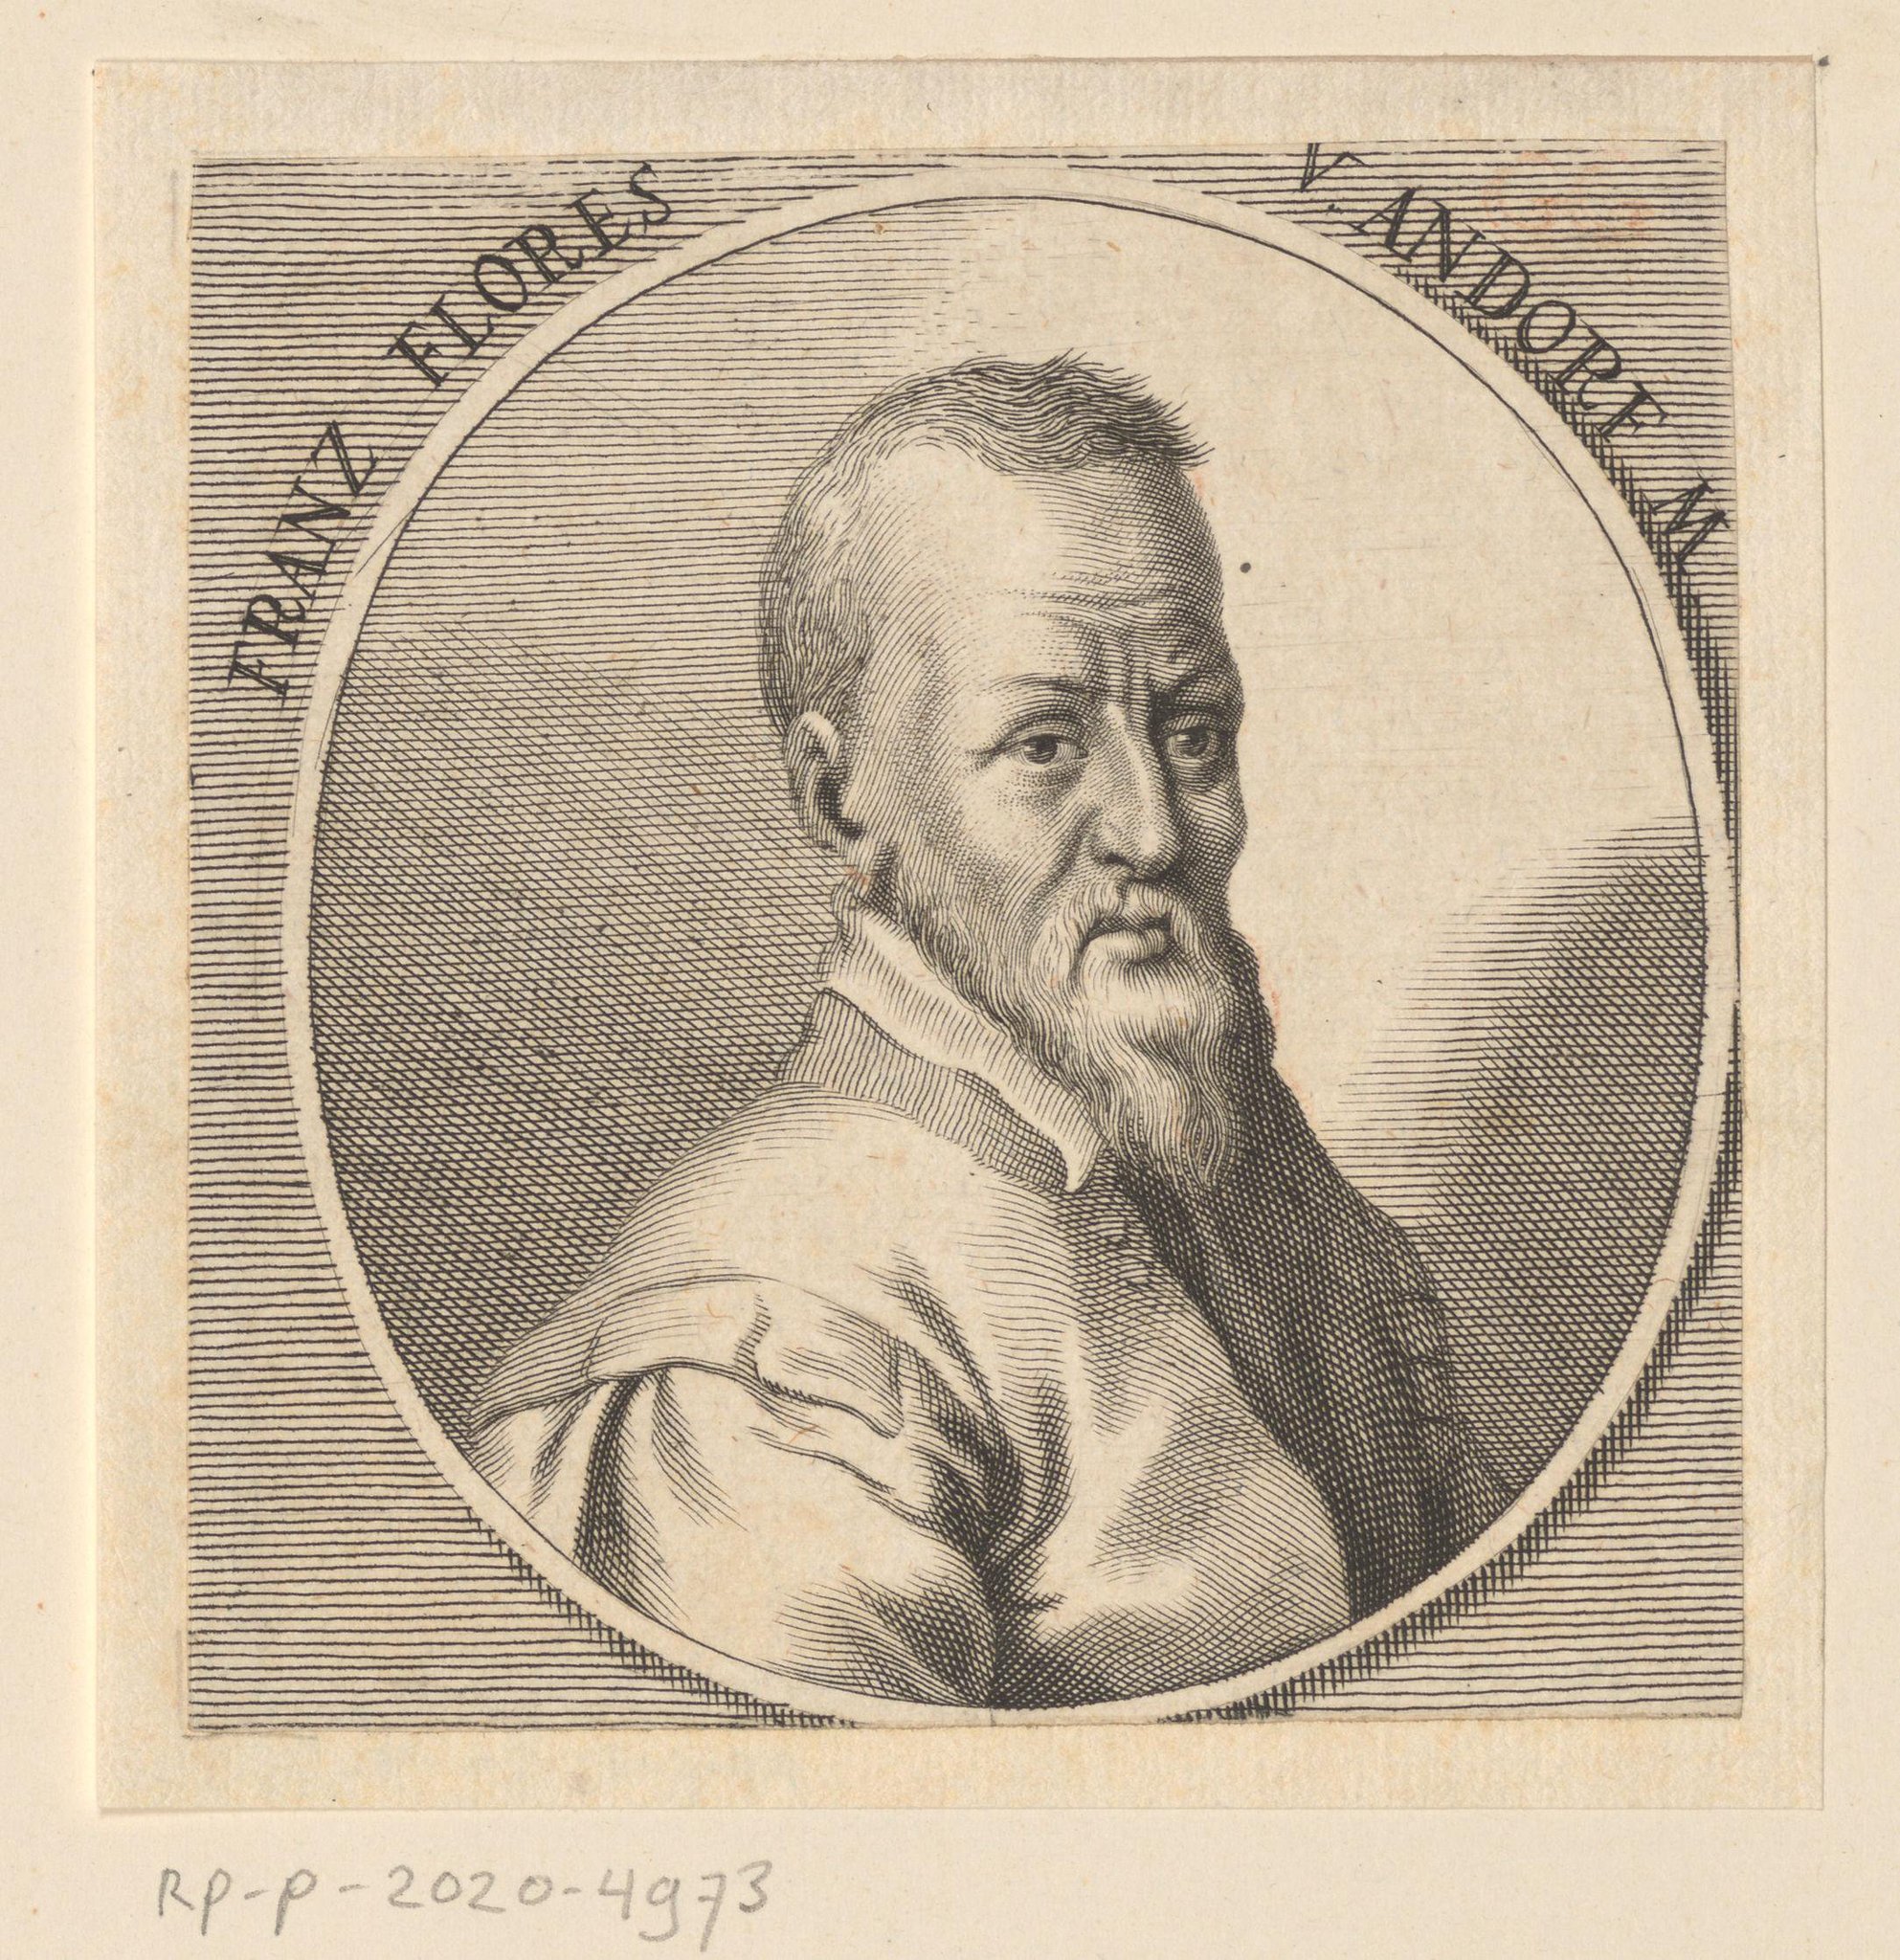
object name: print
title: Portret van Frans Floris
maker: philipp kilian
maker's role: print maker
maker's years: 1628-1693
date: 1675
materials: paper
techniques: engraving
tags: antwerp, print maker, draughtsman, frans floris (i), historical persons, portrait, self-portrait of painter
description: Prent in tweede staat waarschijnlijk gebruikt in: Sandrart, Joachim von. L'Academia Todesca della Architectura, Scultura e Pittura oder Teutsche Academie der Edlen Bau- Bild- und Mahlerey-Künste (...). Neurenberg: Jakob von Sandrart, 1675.